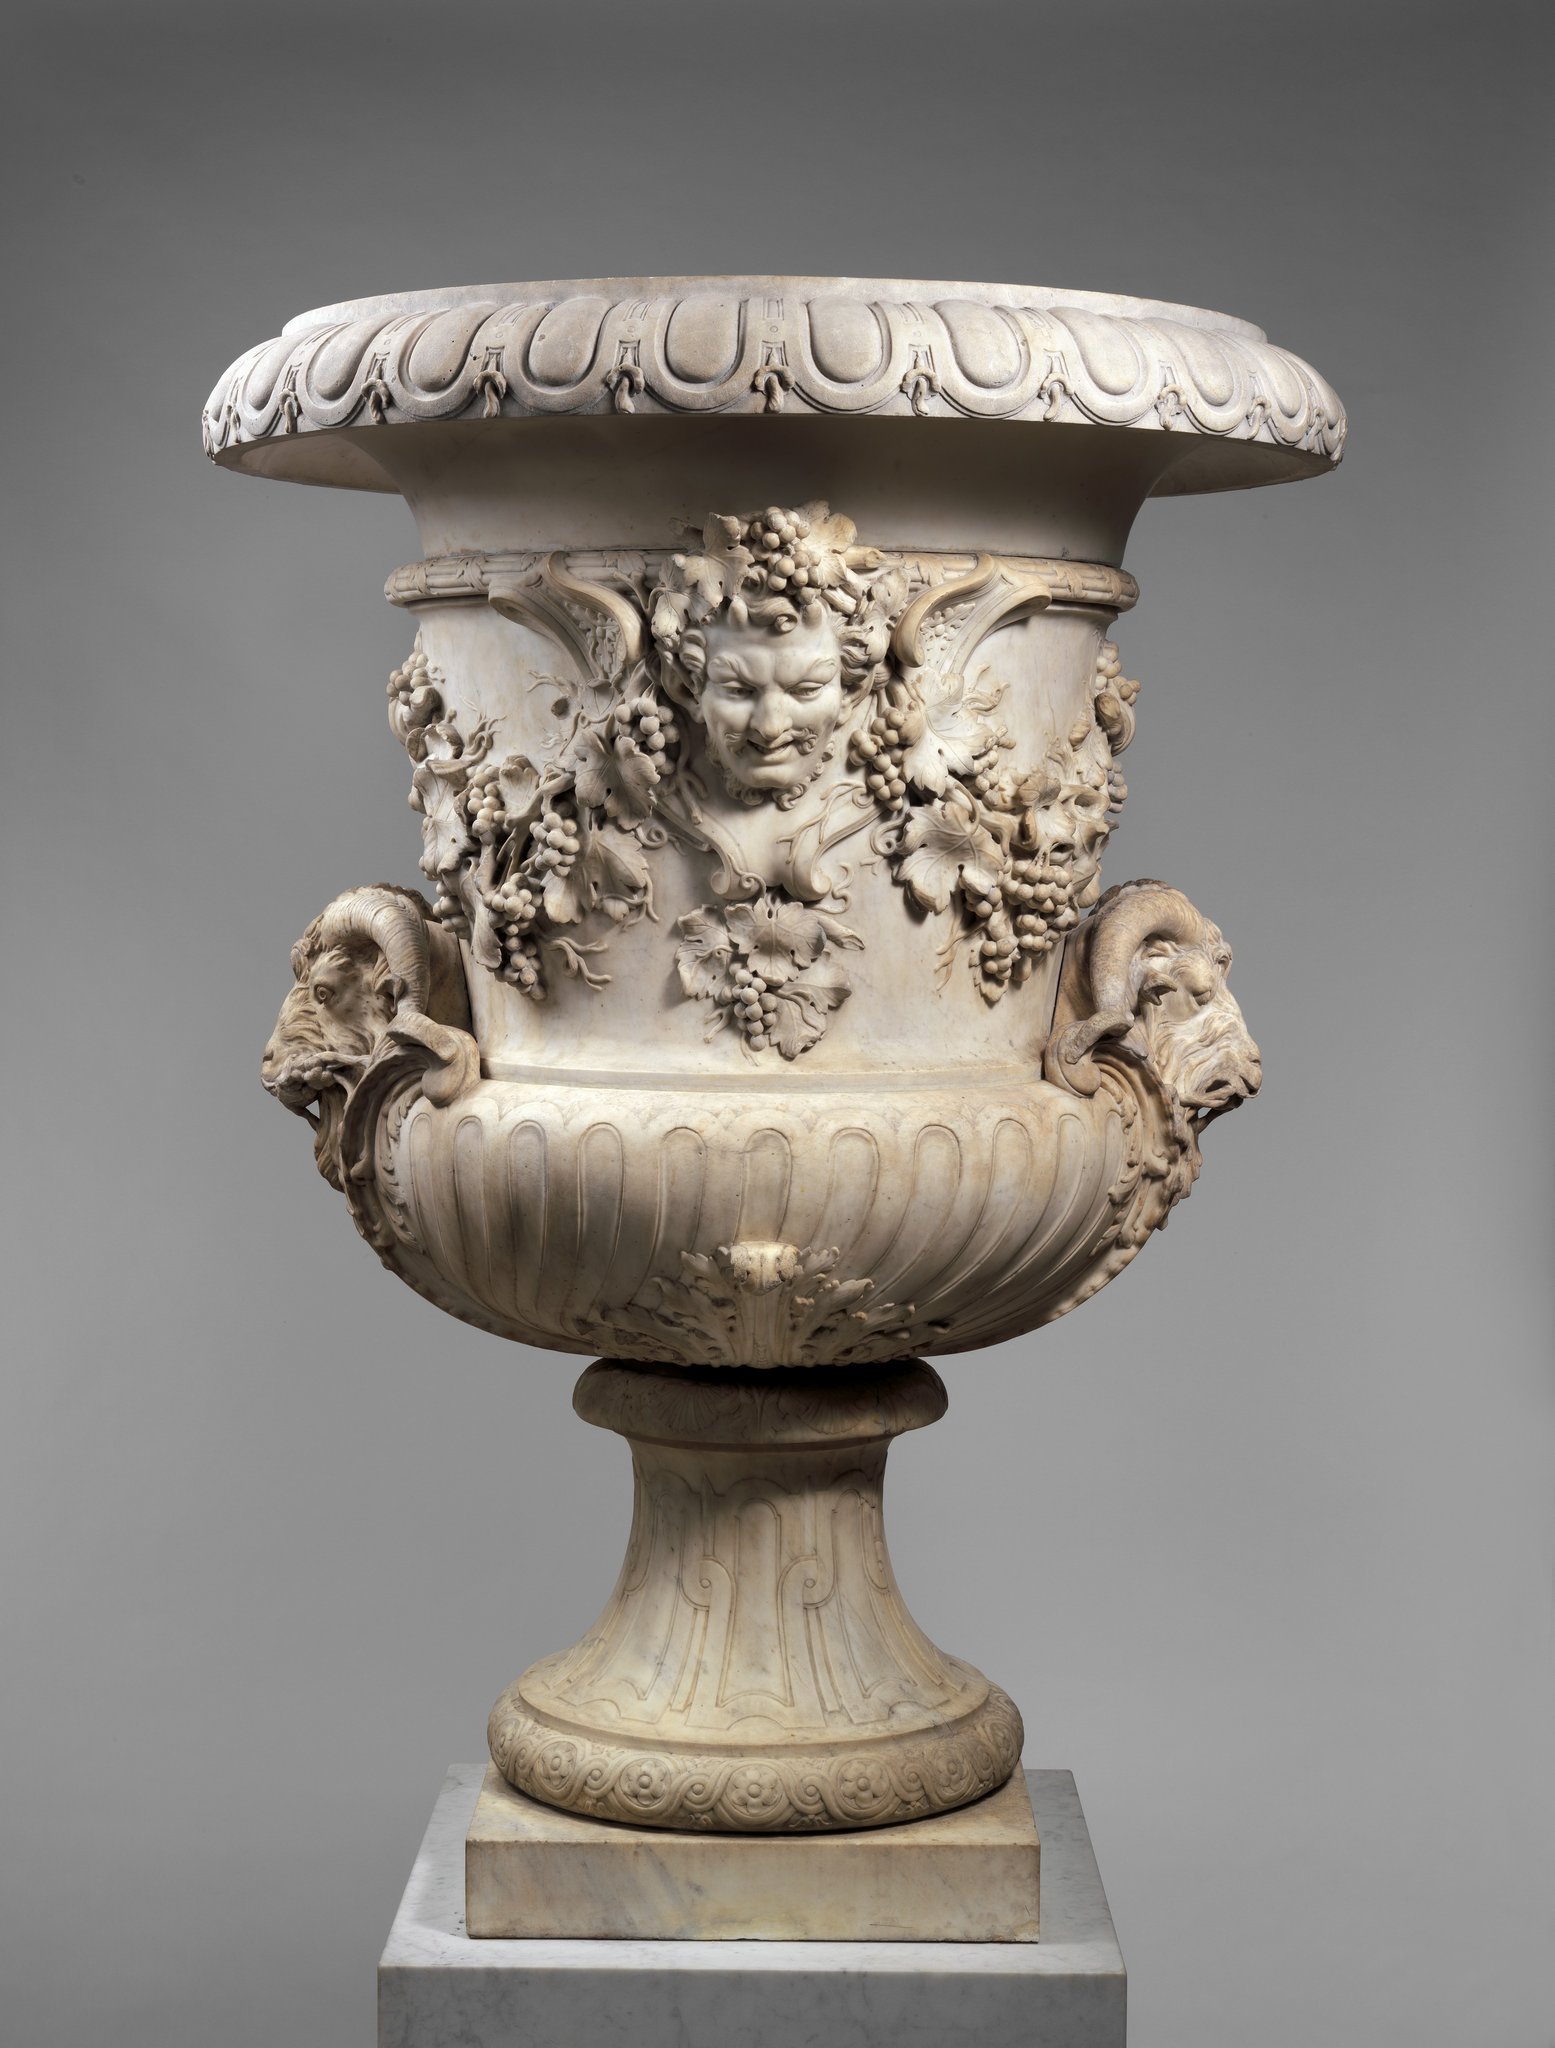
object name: vase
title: Autumn (one of a pair)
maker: nicholas sébastien adam the younger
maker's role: artist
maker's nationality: french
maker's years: 1705-1778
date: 1745-1747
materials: marble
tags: grapes,satyrs,rams,autumn